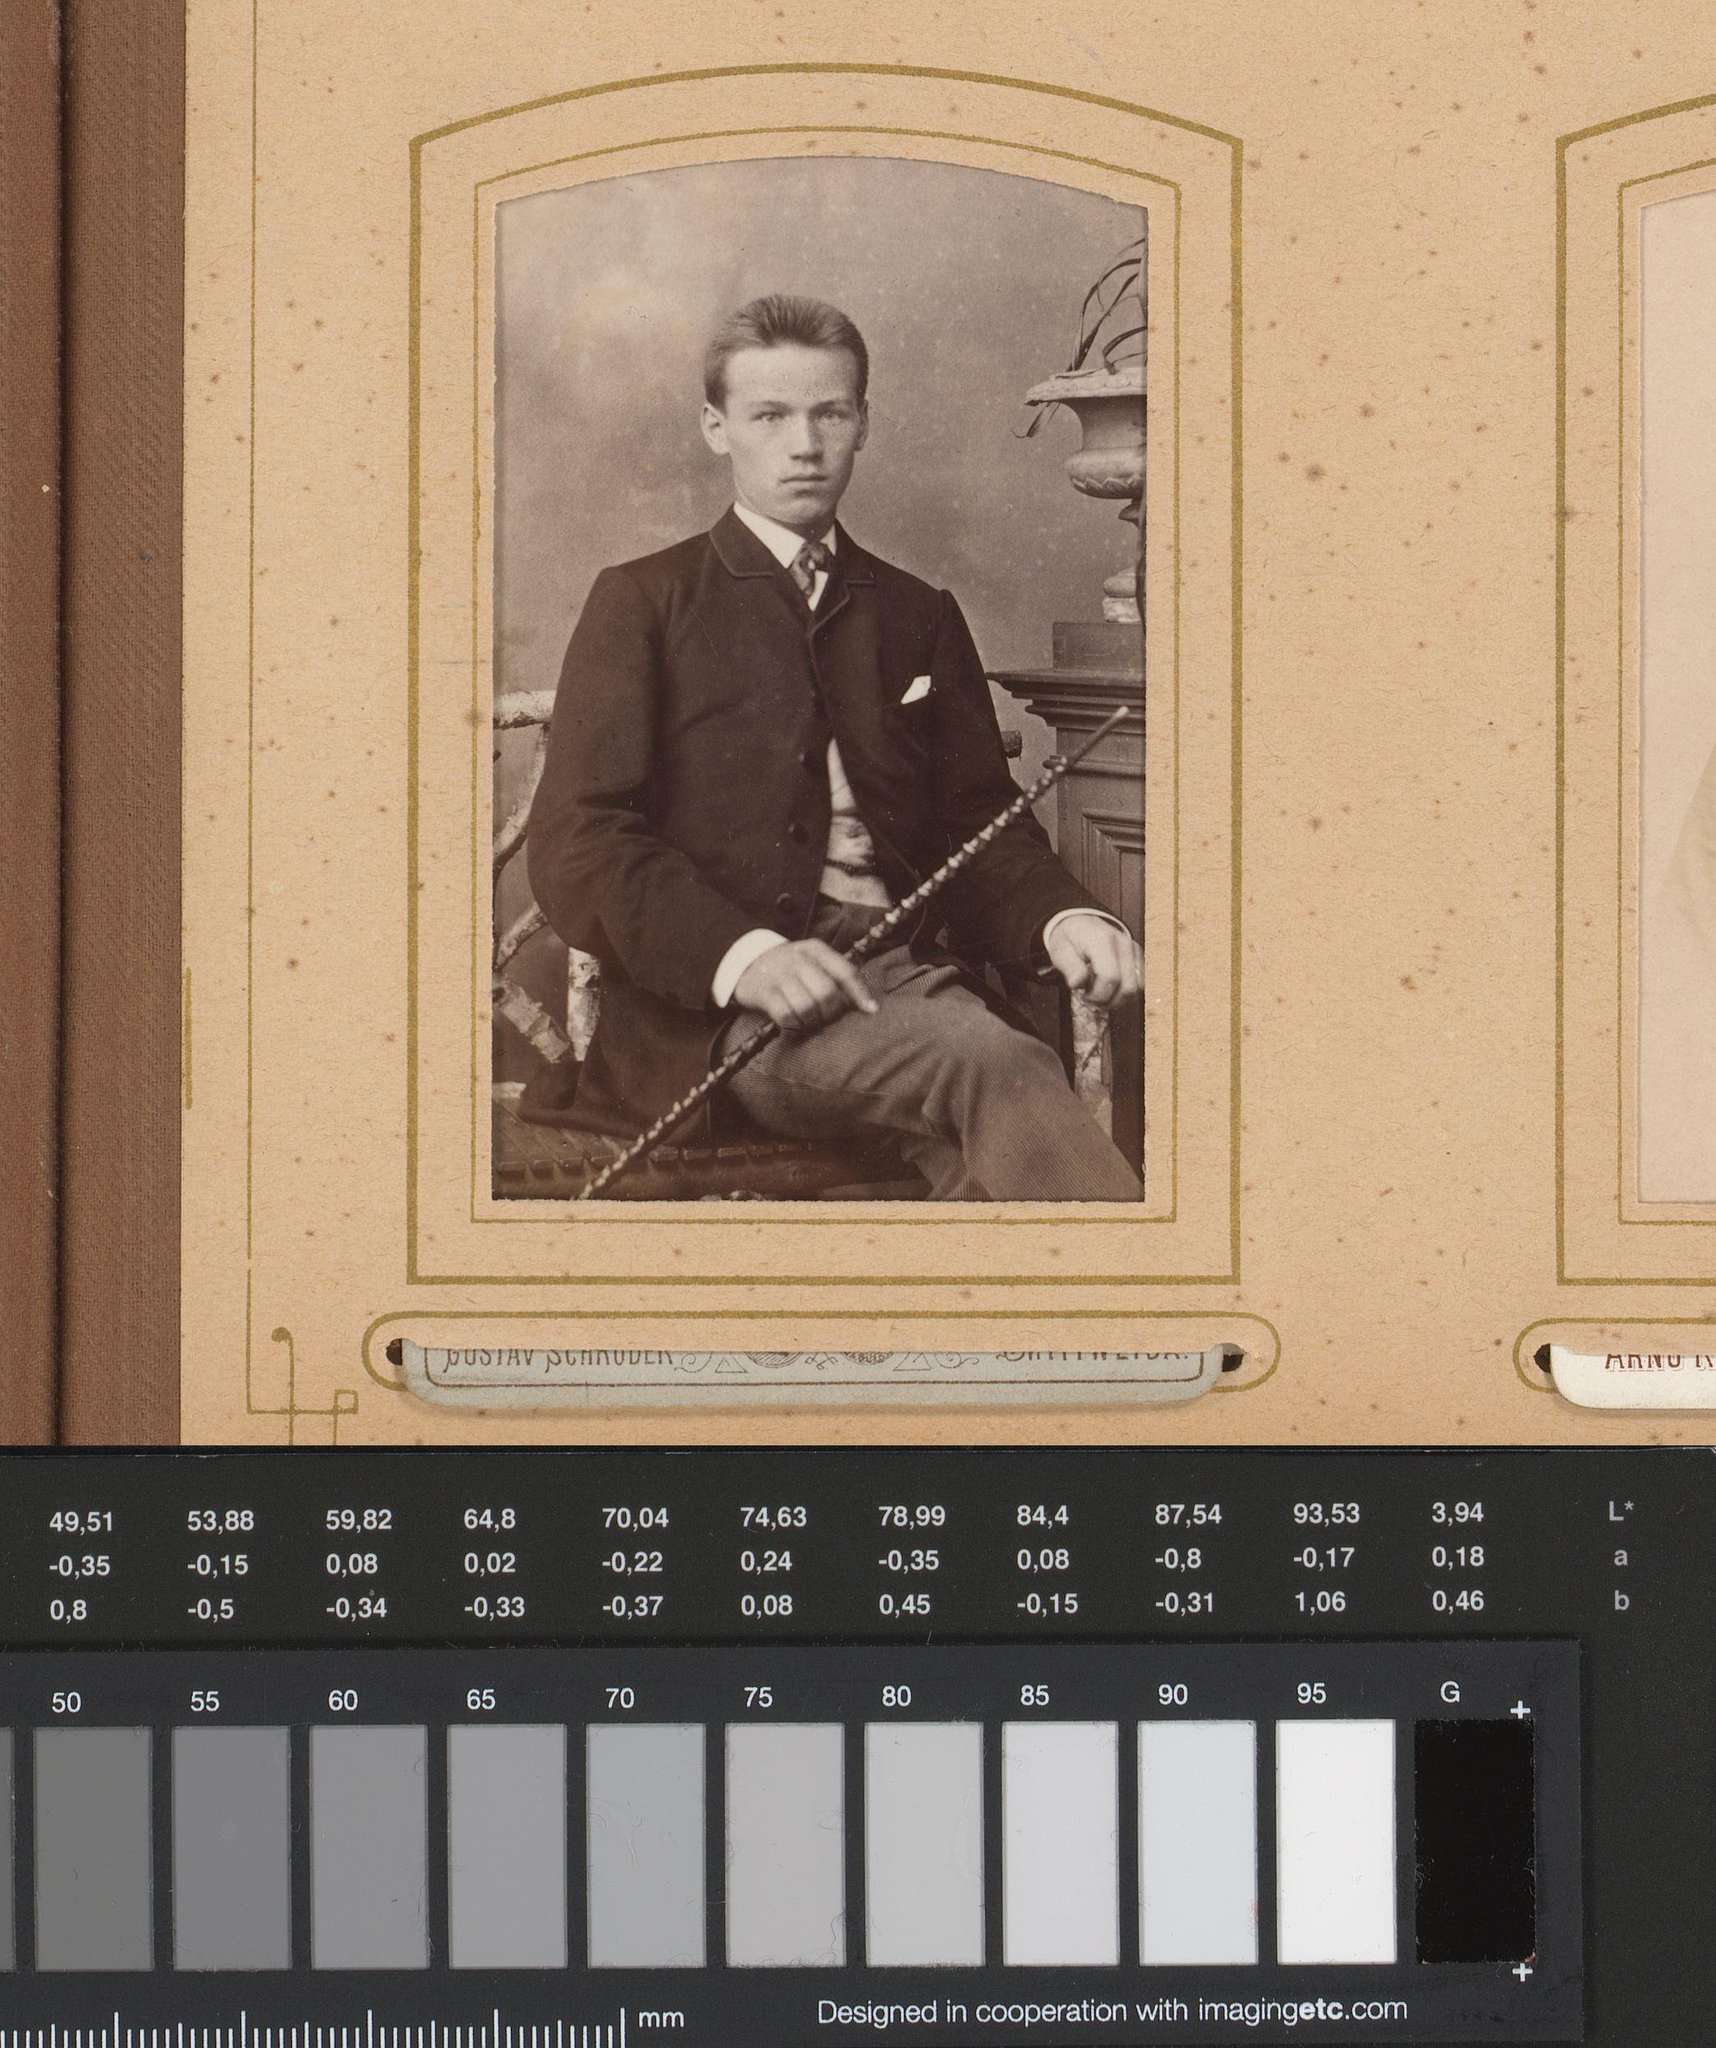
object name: carte de visite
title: Portret van een zittende jonge man met stok in de hand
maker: gustav schröder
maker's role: fotograaf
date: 1860-1900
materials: cardboard, photographic support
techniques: albumen print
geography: mittweida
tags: sitting figure, walking-stick, staff, historical persons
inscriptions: inscription: ‘GUSTAV SCHRÖDER/ ATELIER/ FÜR PHOTOGRAPHIE./ MITTWEIDA/ Rochlitzer-Strasse 234./ AUFNAHME und VERGRÖSSERUNG/ von Portraits/ bis zur Lebensgrösse./ Die Platte wird für Nachbestellung aufbewahrt.’